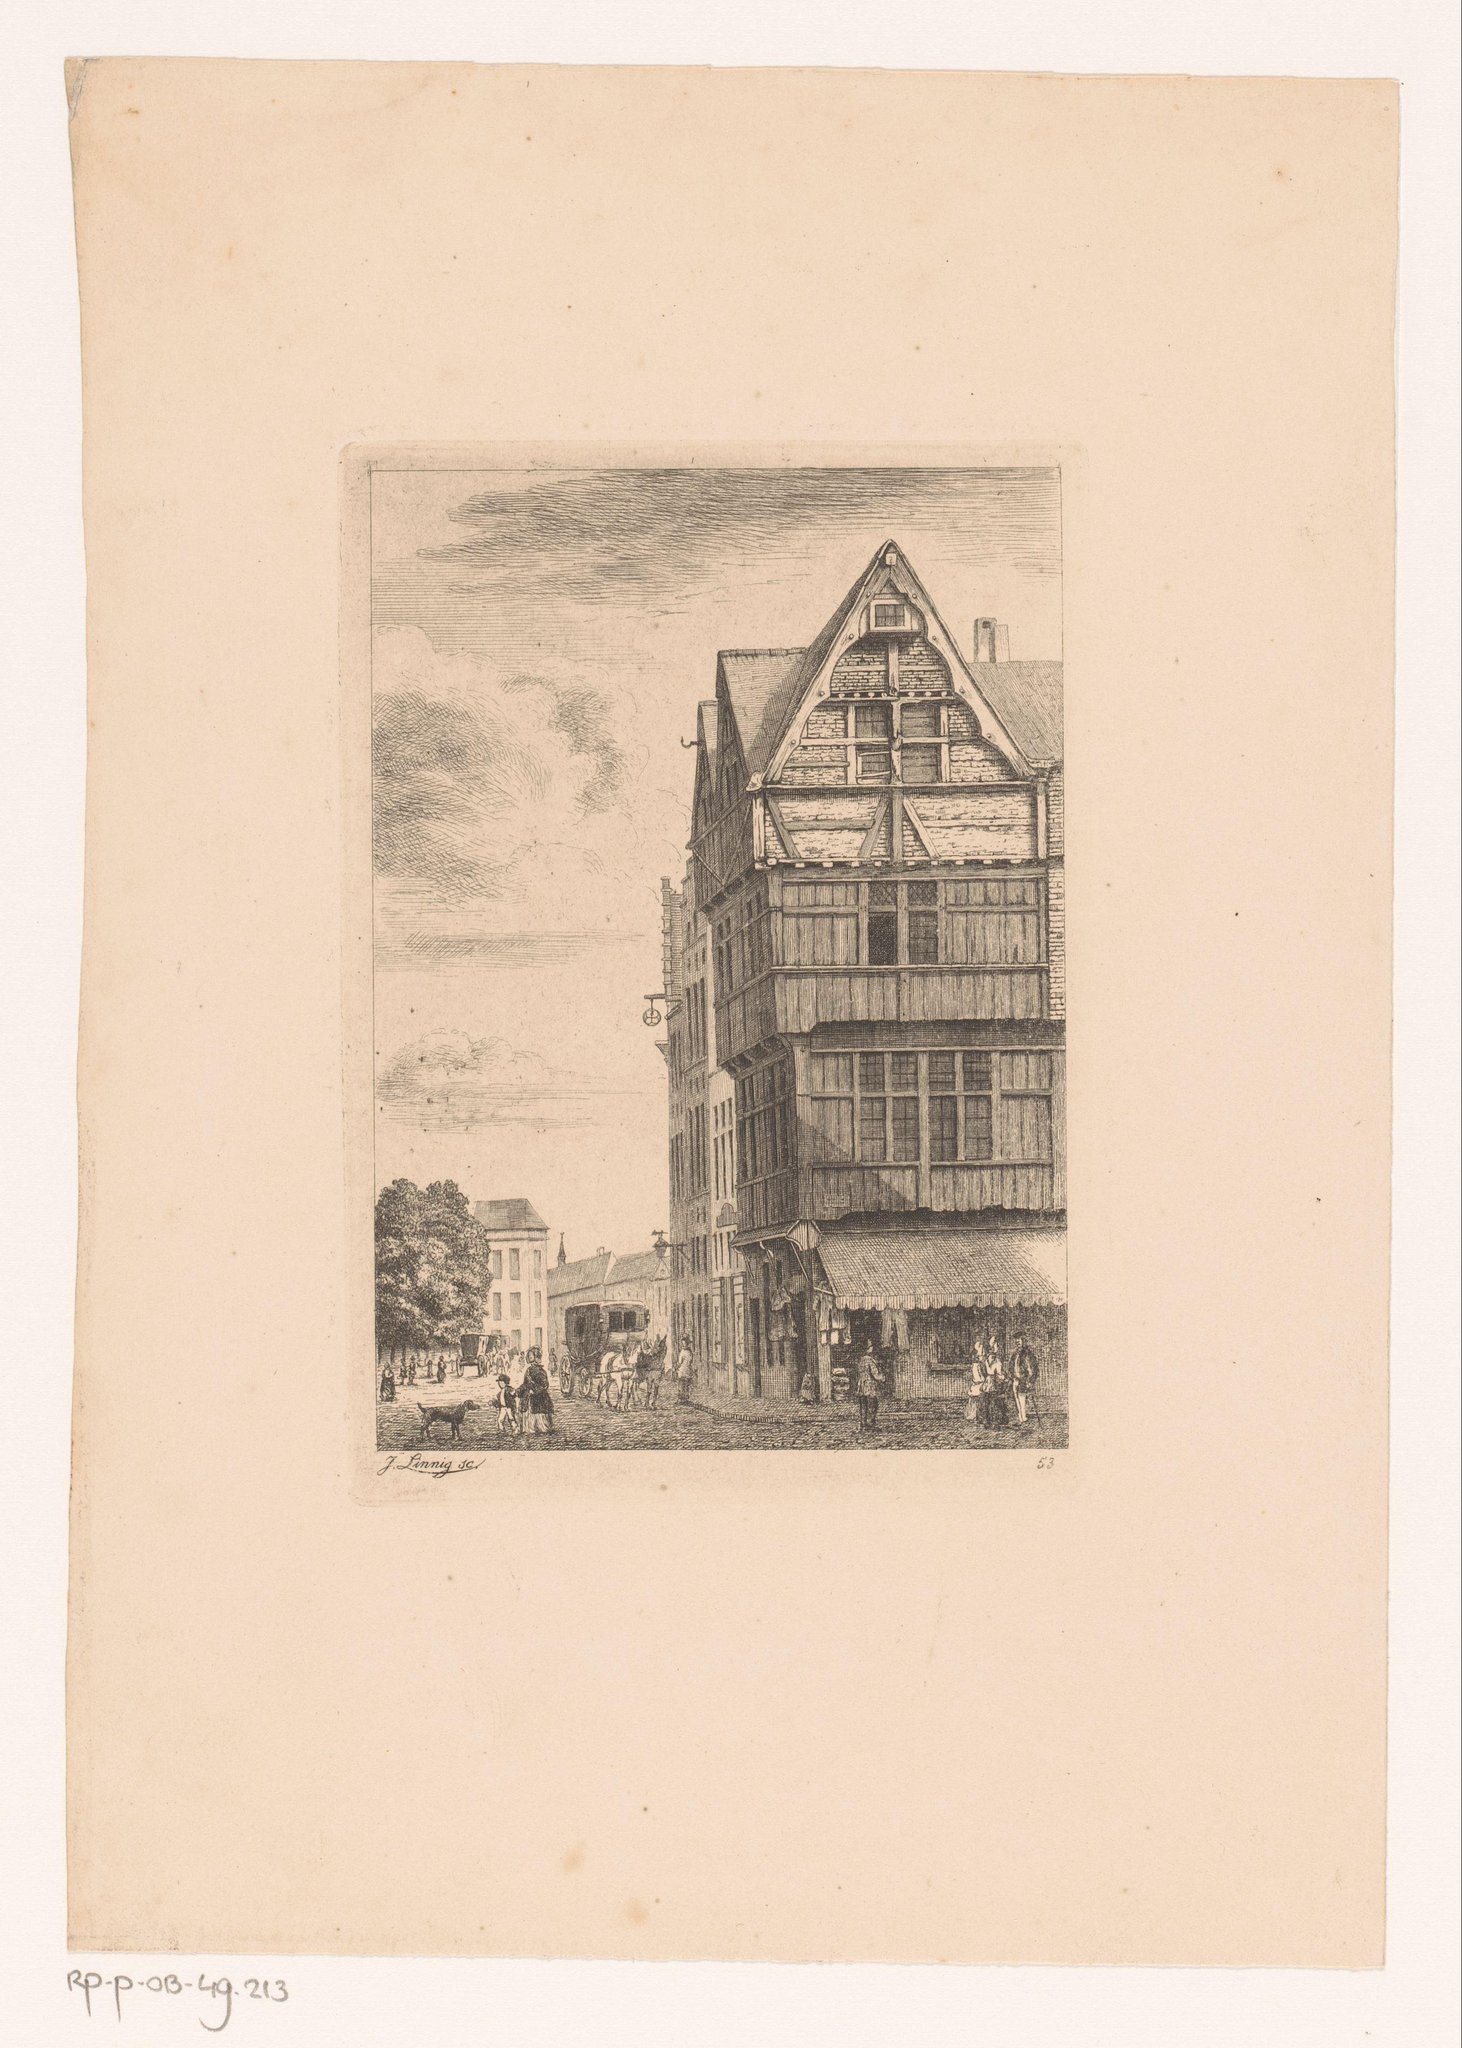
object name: print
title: Houten gevel in de Kammenstraat in Antwerpen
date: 1868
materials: paper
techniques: etching, intaglio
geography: antwerp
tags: façade (of house or building), antwerp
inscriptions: collector's mark: Lugt 2228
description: Prent uit: Mertens, F.H. Album historique de la ville d'Anvers [...]. Antwerpen: J.E. Buschmann, 1868.